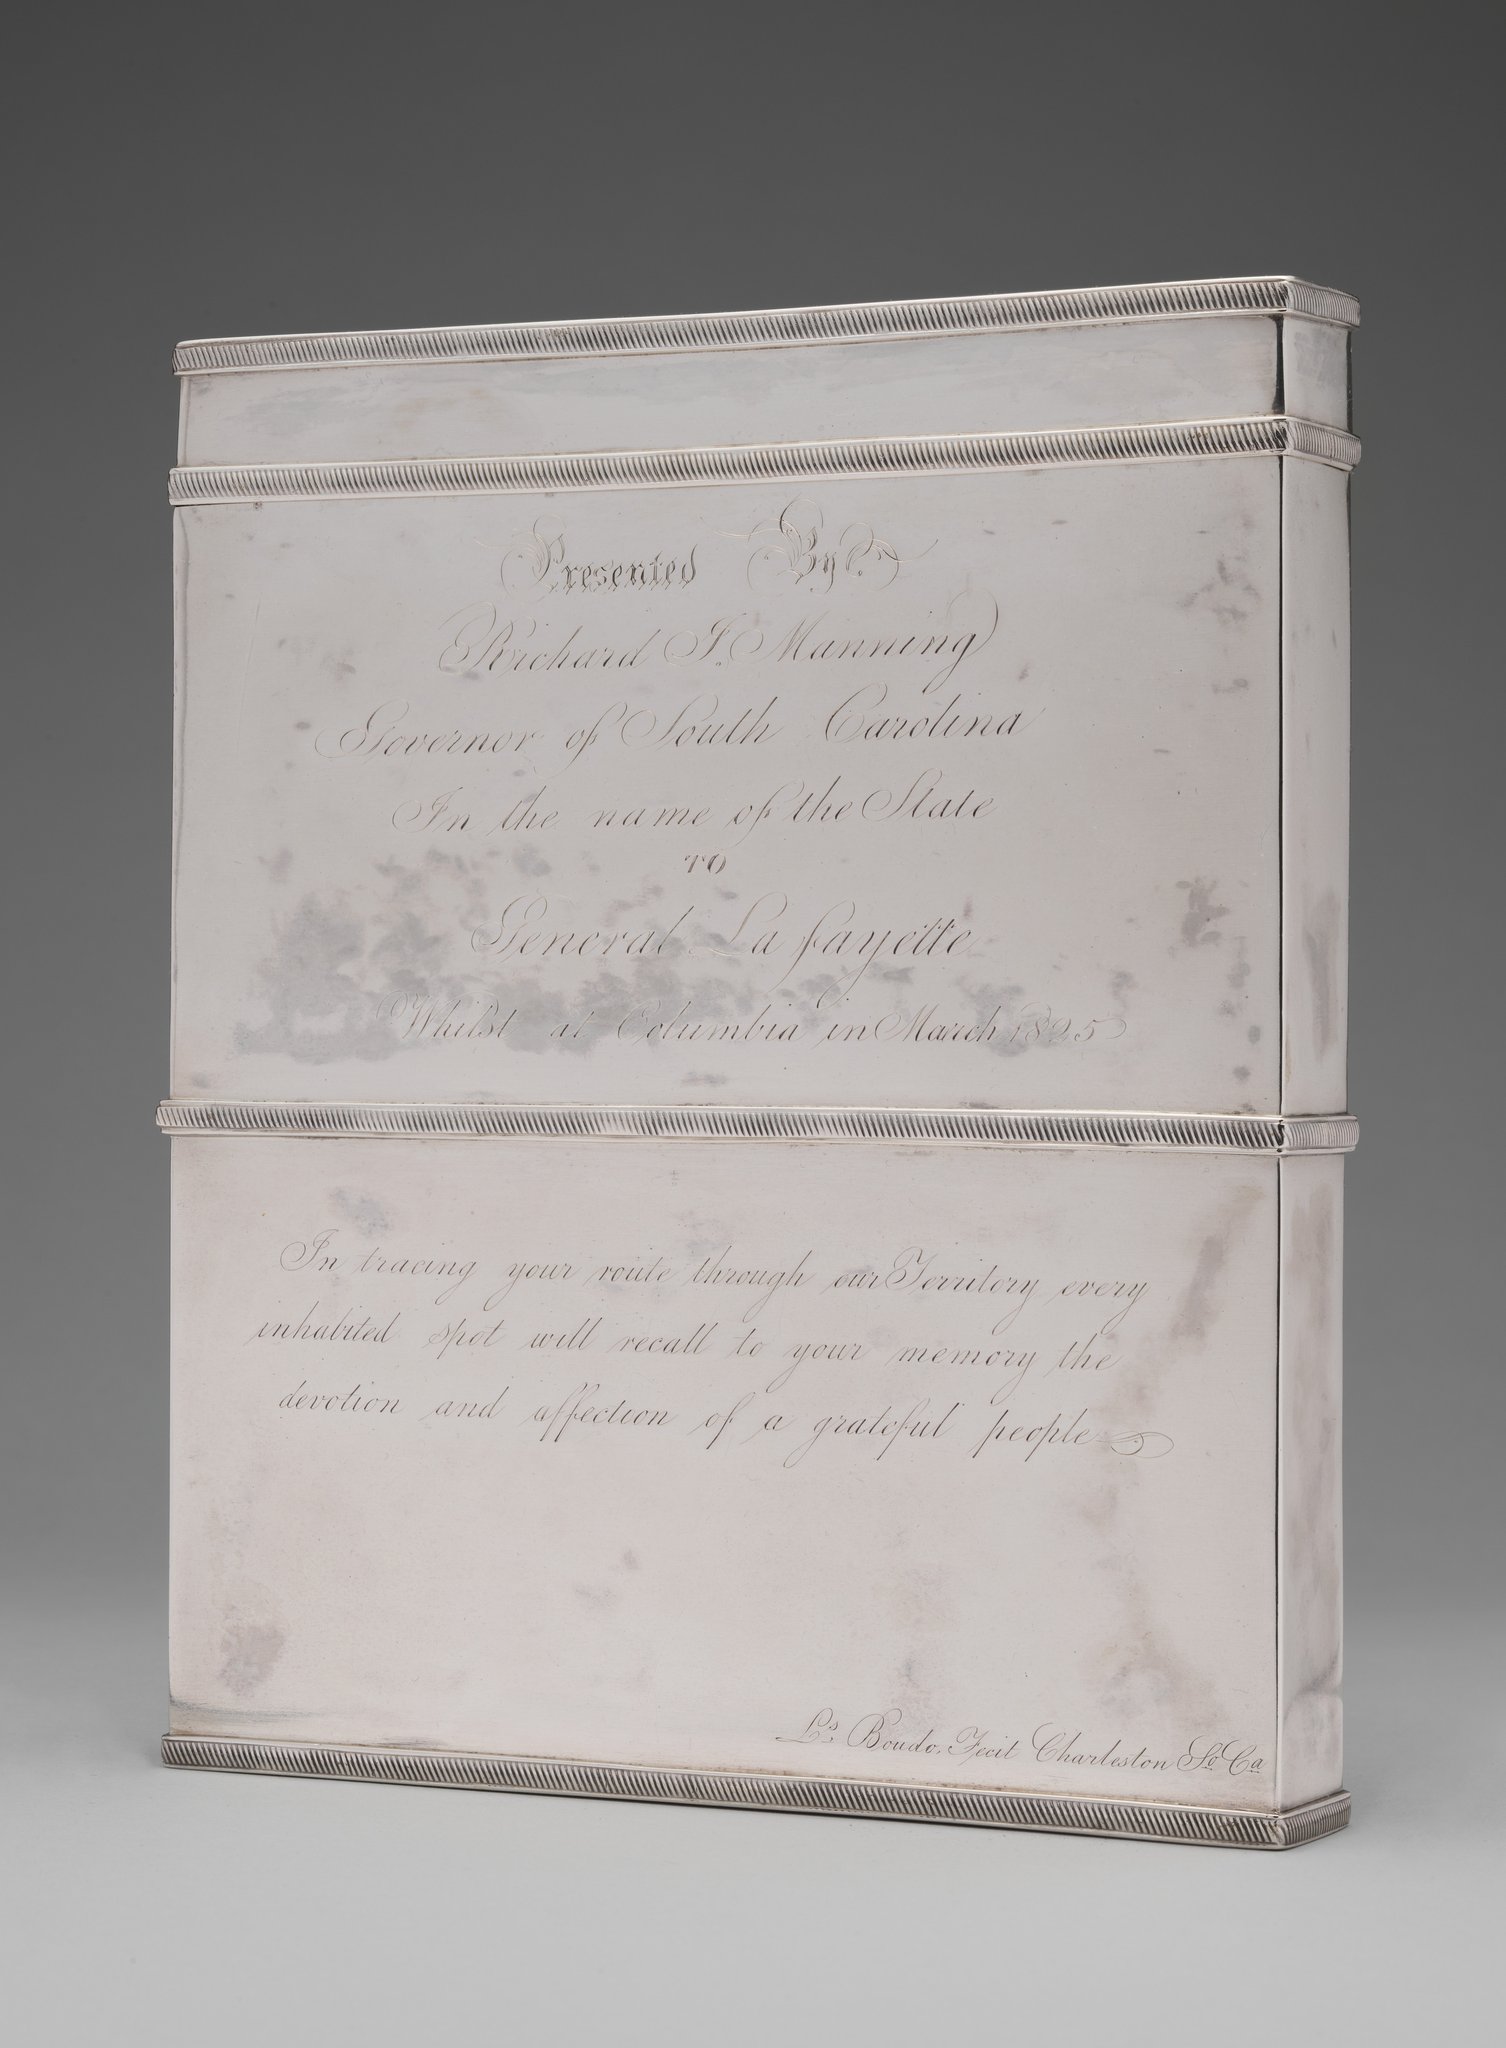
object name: case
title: Map Case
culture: american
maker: louis boudo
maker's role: maker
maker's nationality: american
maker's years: 1786-1827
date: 1825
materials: silver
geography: united states